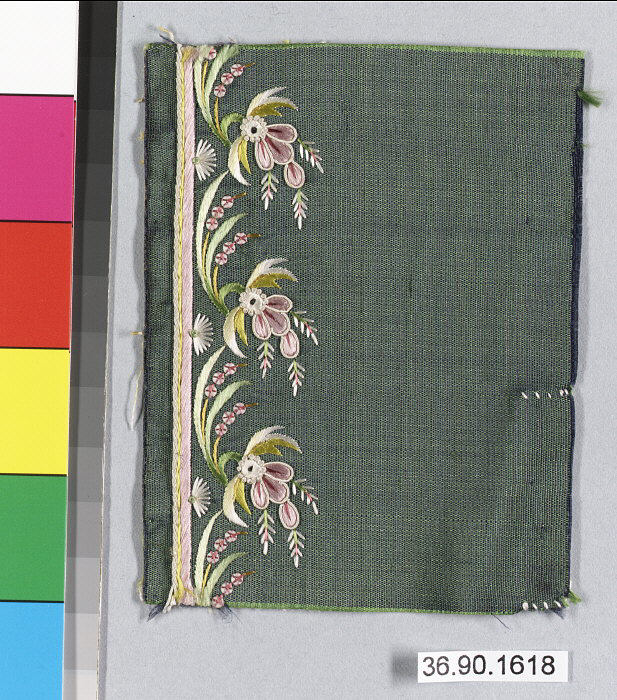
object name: sample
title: Embroidery sample for a man’s suit or waistcoat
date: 1785-1815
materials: silk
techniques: embroidery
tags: flowers